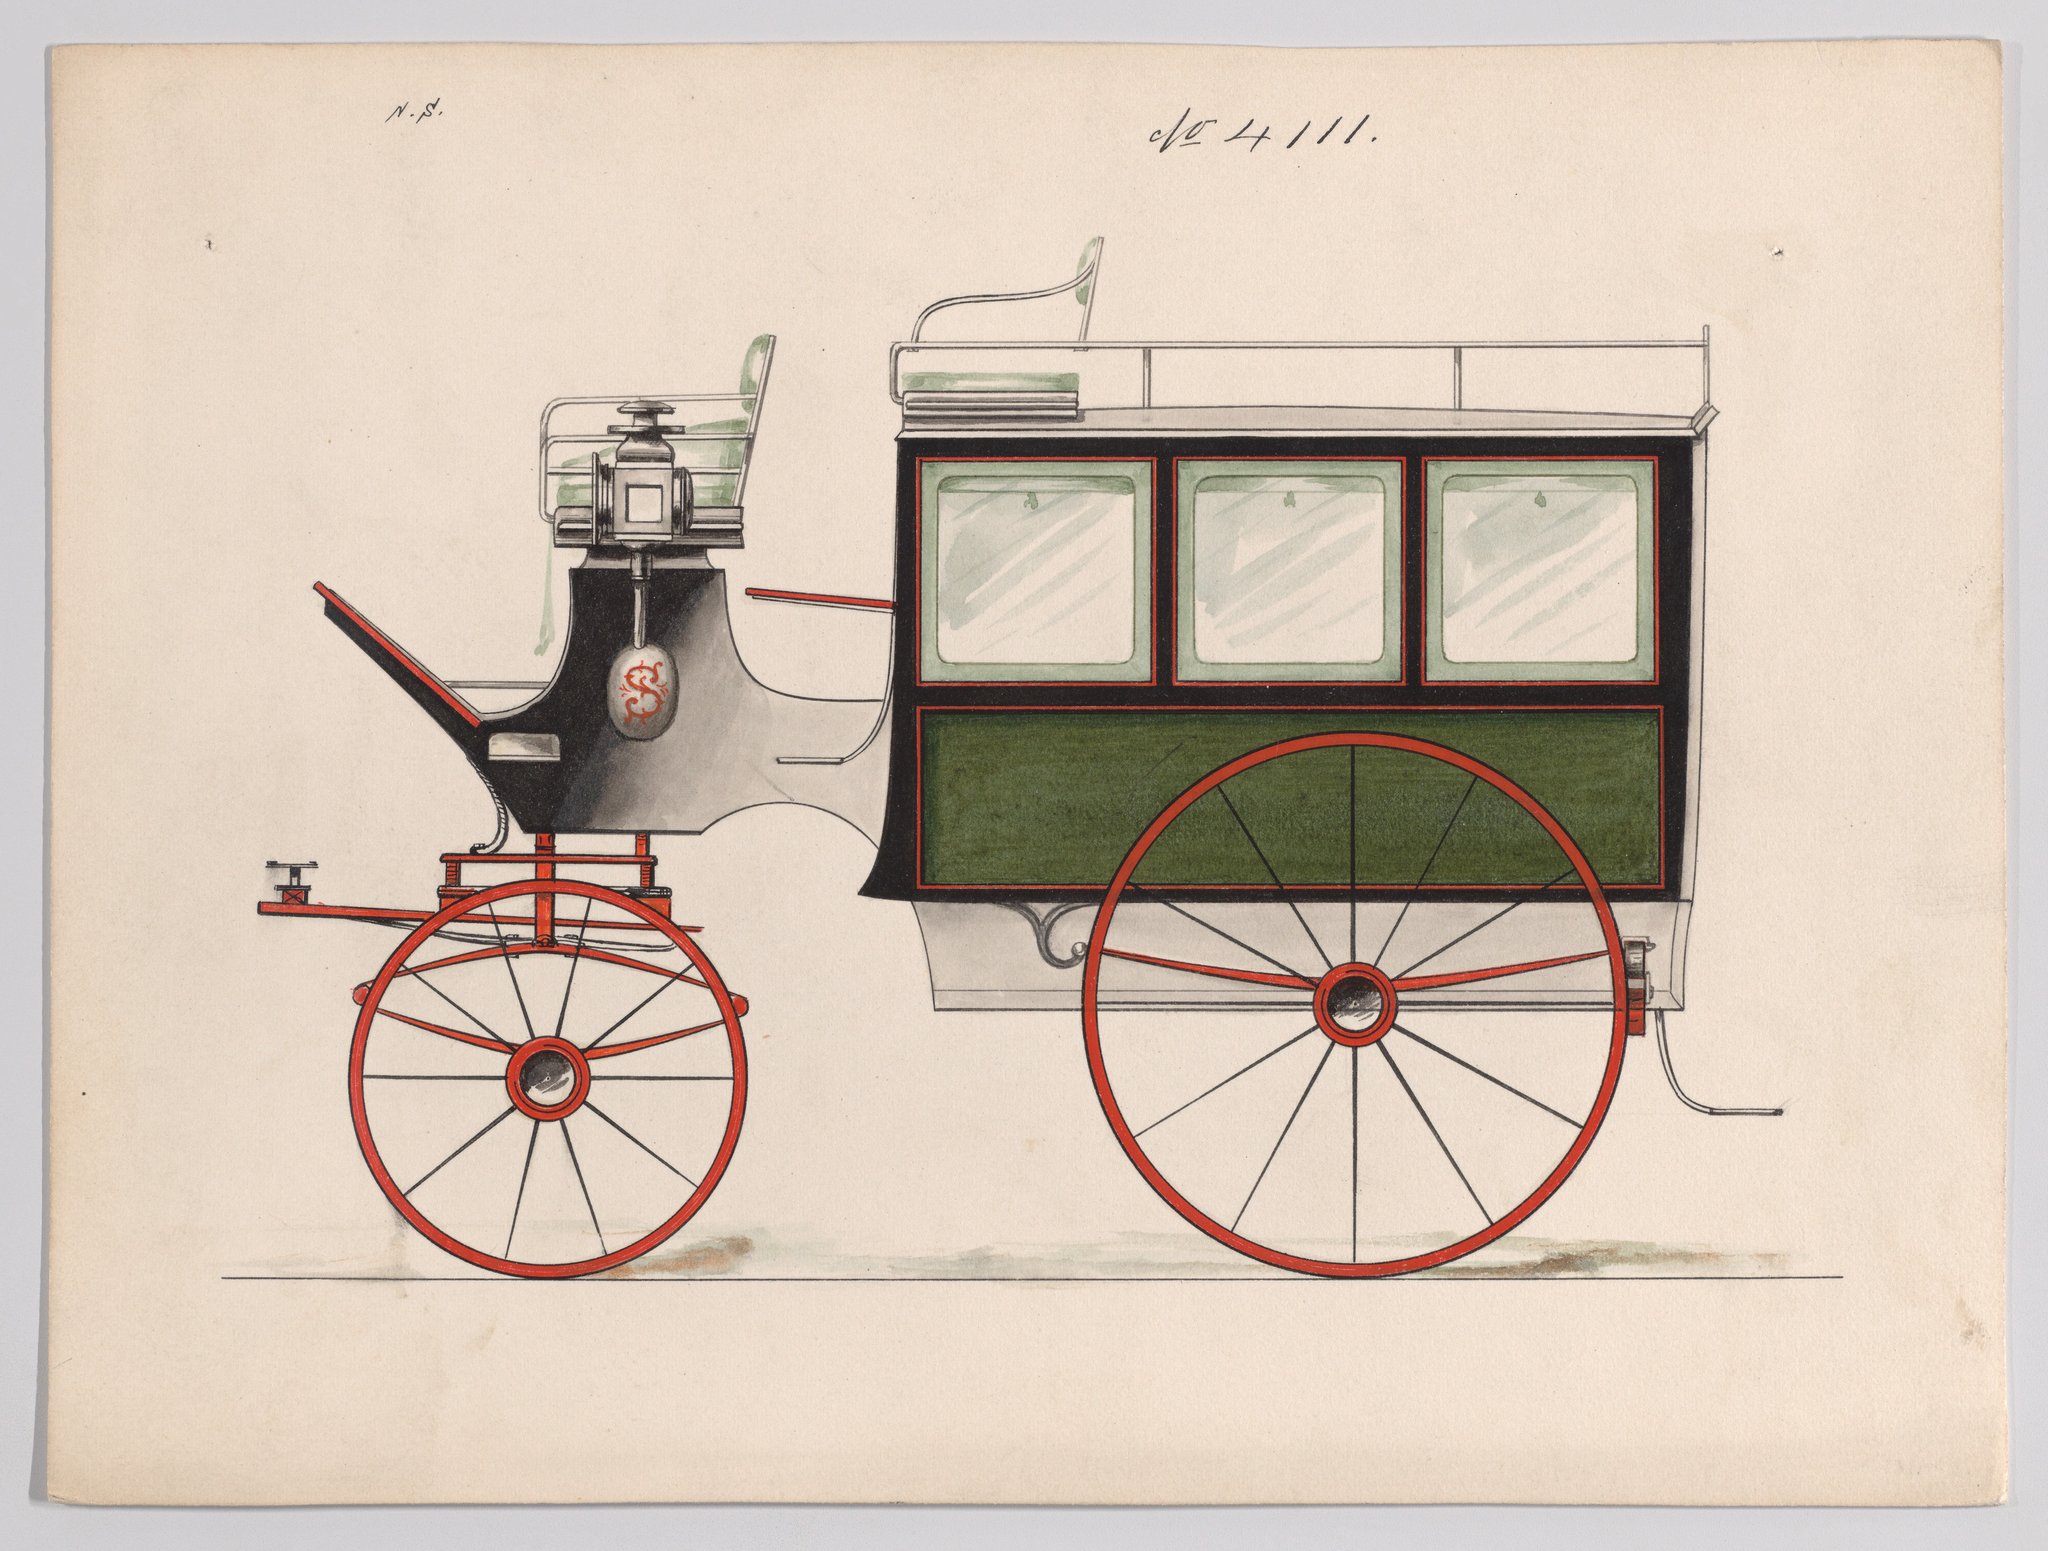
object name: drawing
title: Design for Omnibus or Wagonette, no. 4111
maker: brewster & co.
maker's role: manufacturer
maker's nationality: american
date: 1890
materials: gouache, gum arabic, ink, watercolor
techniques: pen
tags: carriages